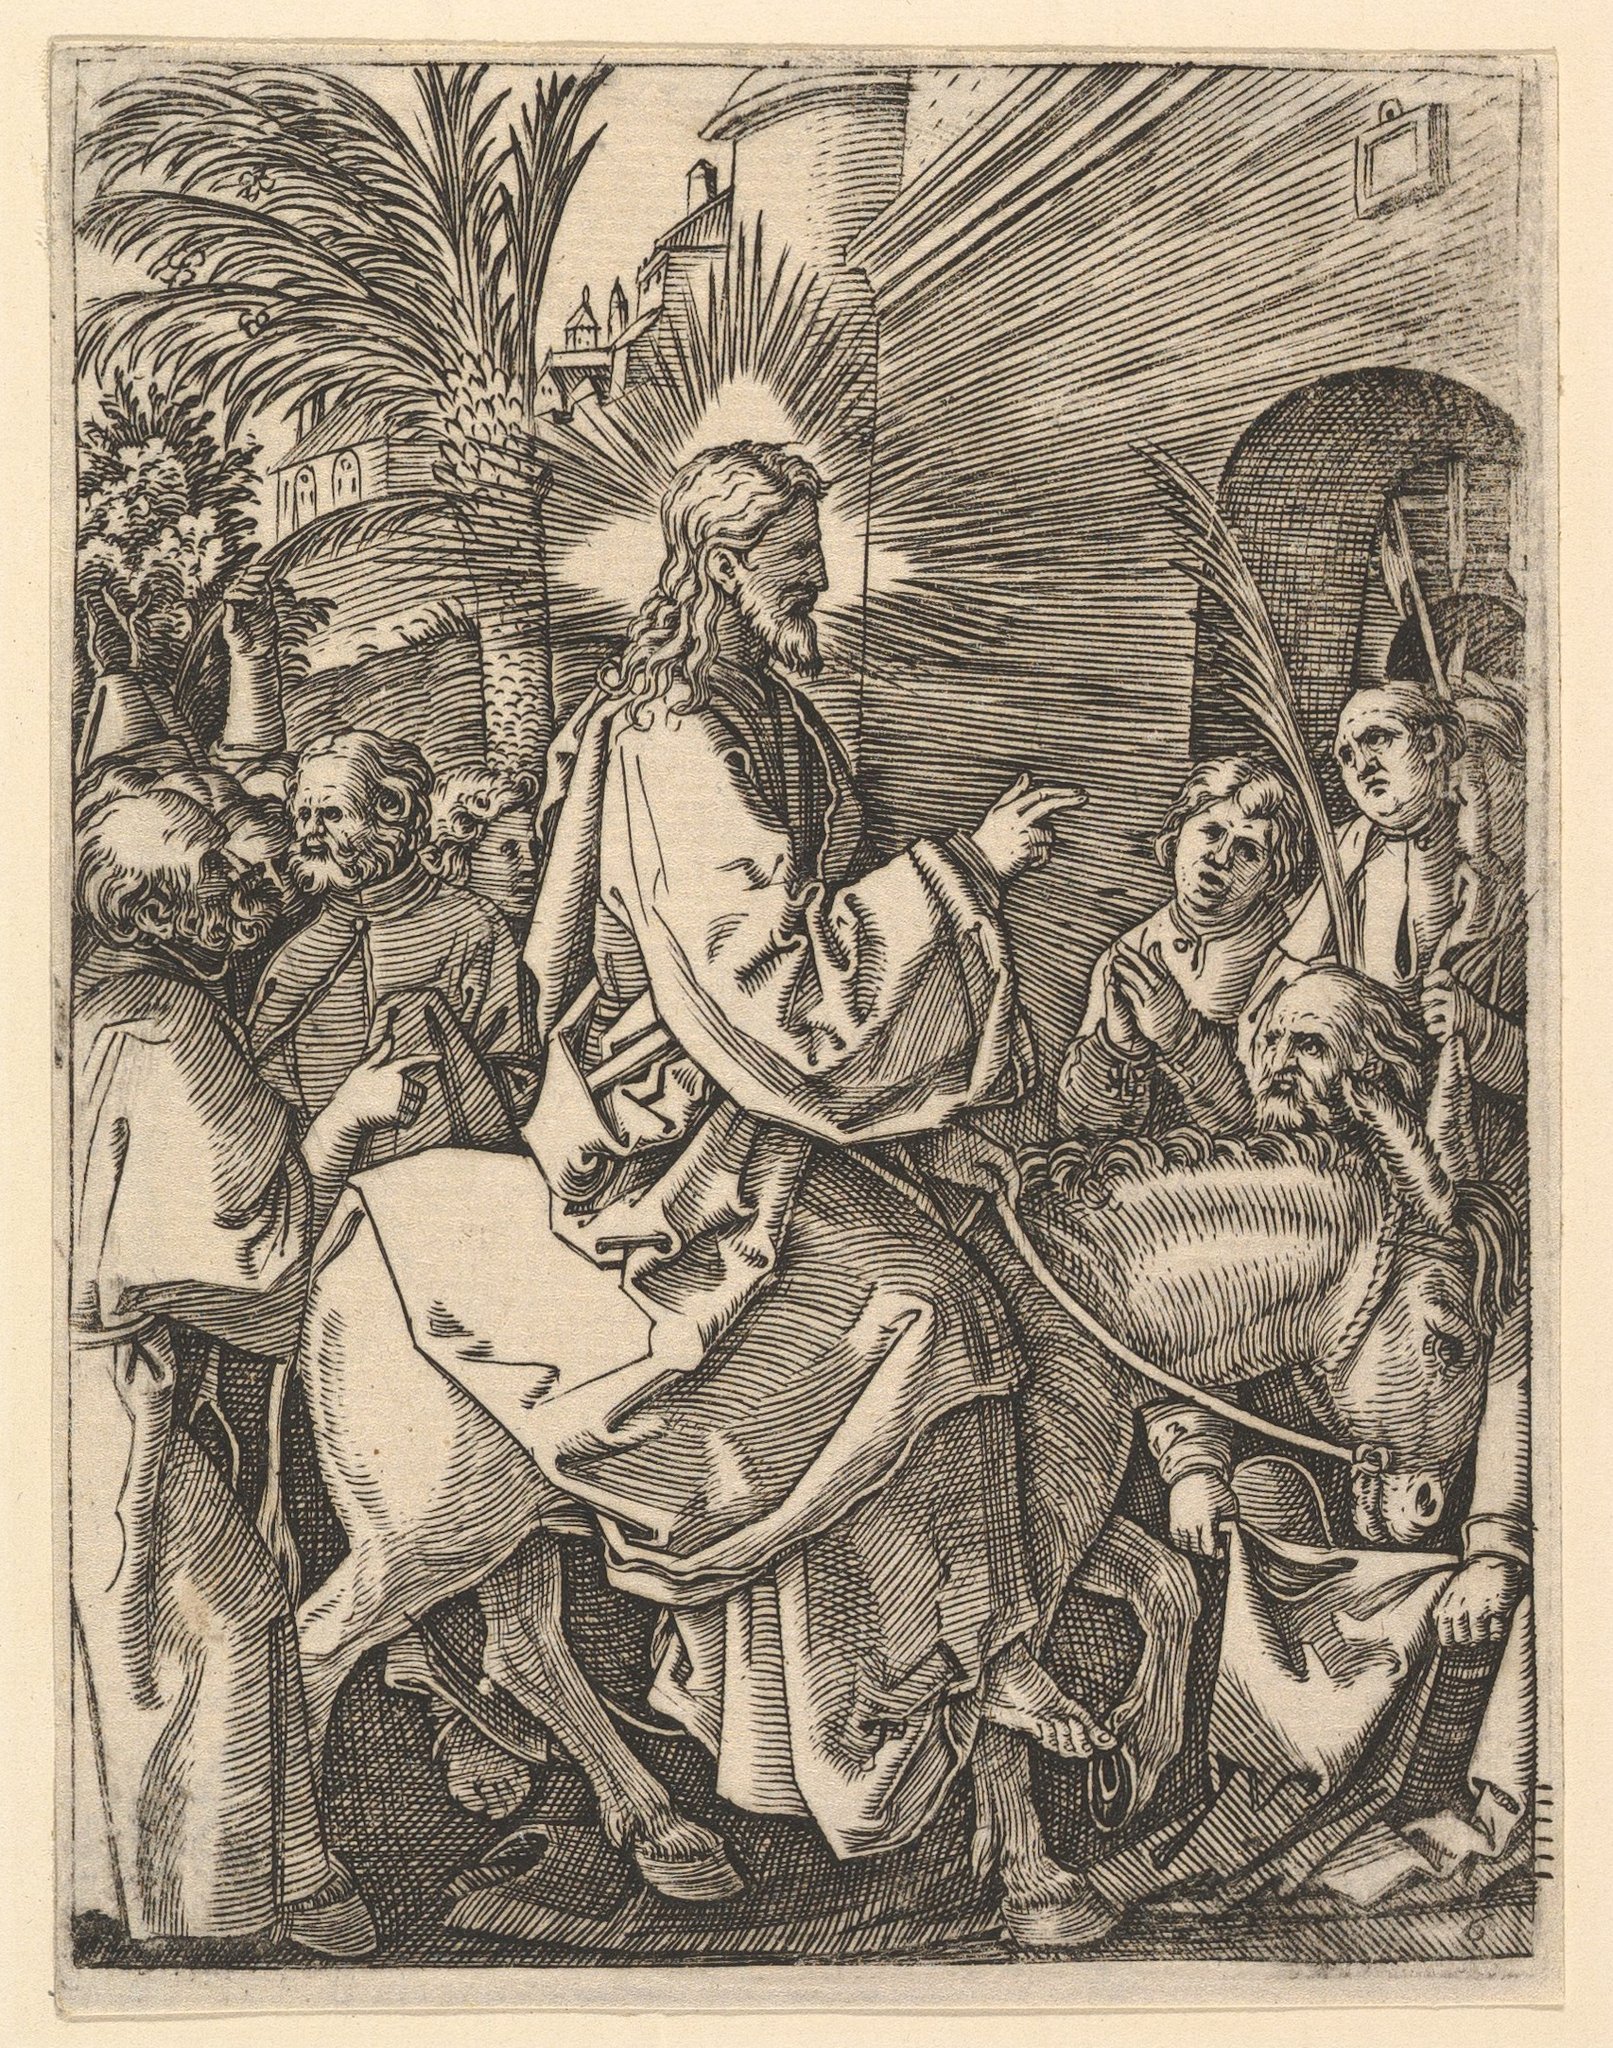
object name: print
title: The Entry into Jerusalem; Christ riding on a donkey towards an arched city gate; an elderly man spreads out his cloak on the road, from "The Passion of Christ", after Dürer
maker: marcantonio raimondi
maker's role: artist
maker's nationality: italian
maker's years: 1475-1534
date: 1500-1534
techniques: engraving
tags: men,donkeys,christ